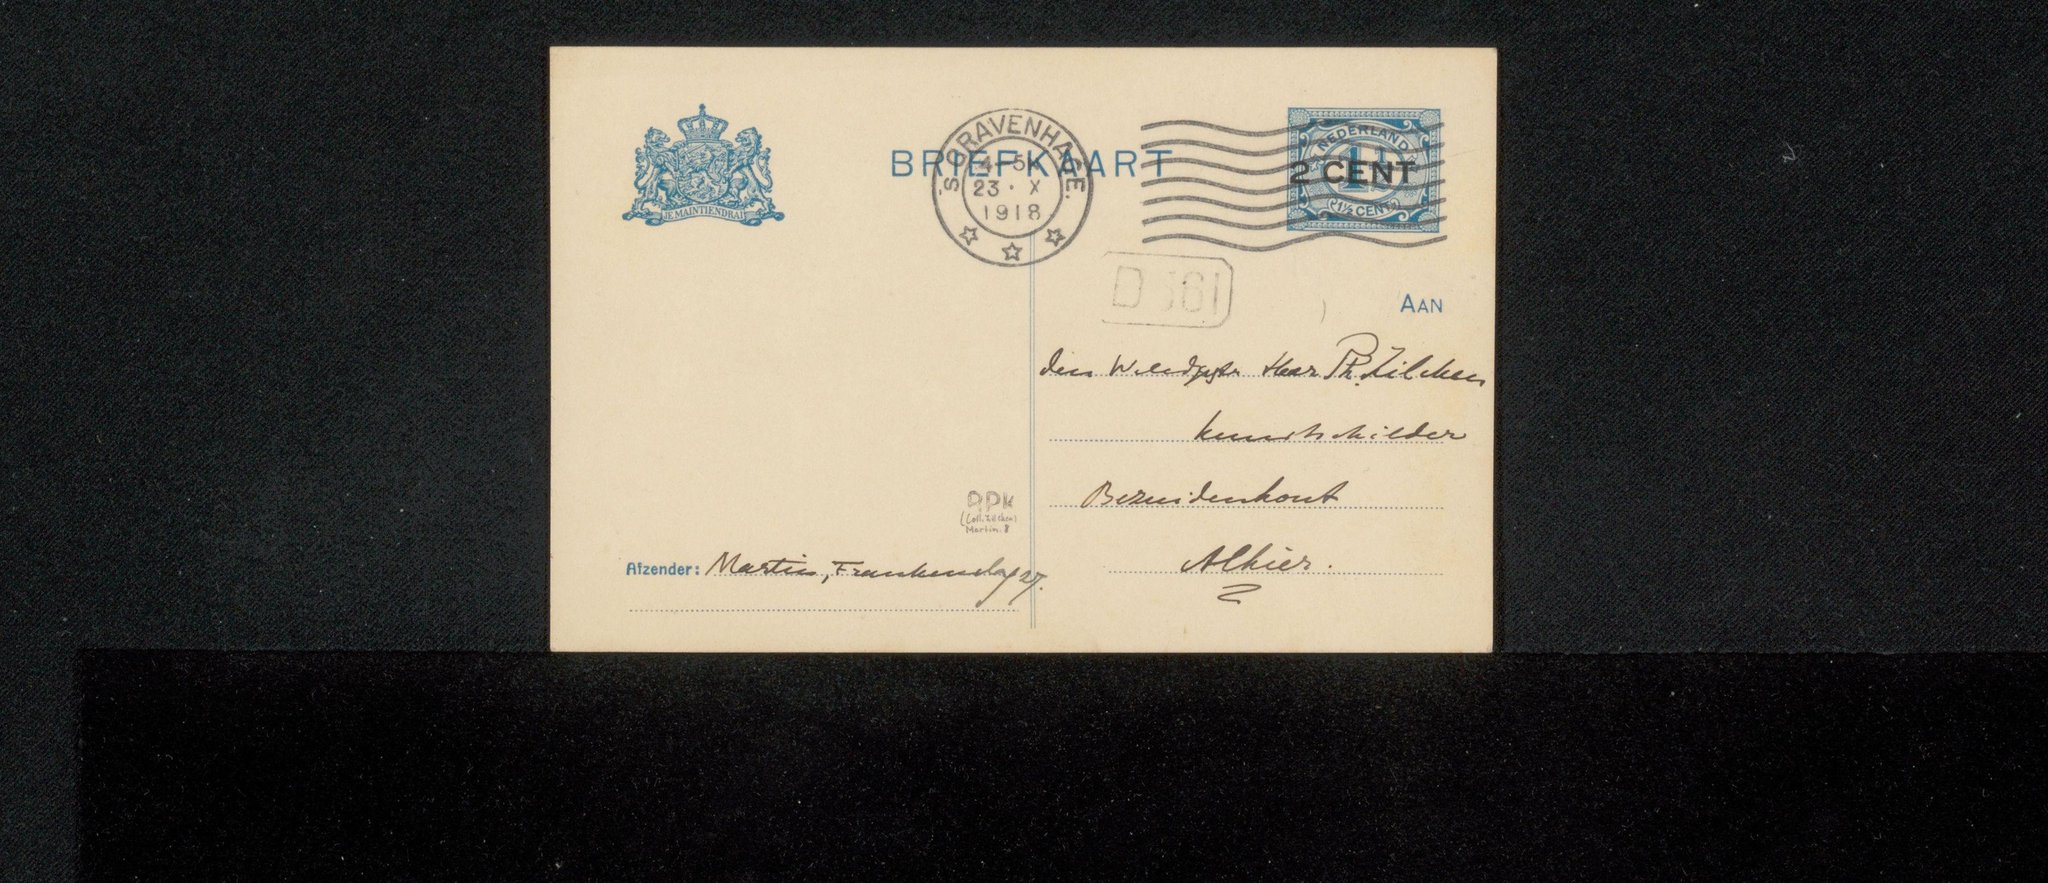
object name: postcard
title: Briefkaart aan Philip Zilcken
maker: wilhelm martin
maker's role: draughtsman, painter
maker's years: 1876-1954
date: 1918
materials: cardboard, ink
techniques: pen, writing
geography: the hague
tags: the hague, painter, draughtsman, philip zilcken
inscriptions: collector's mark: ‘RPK’